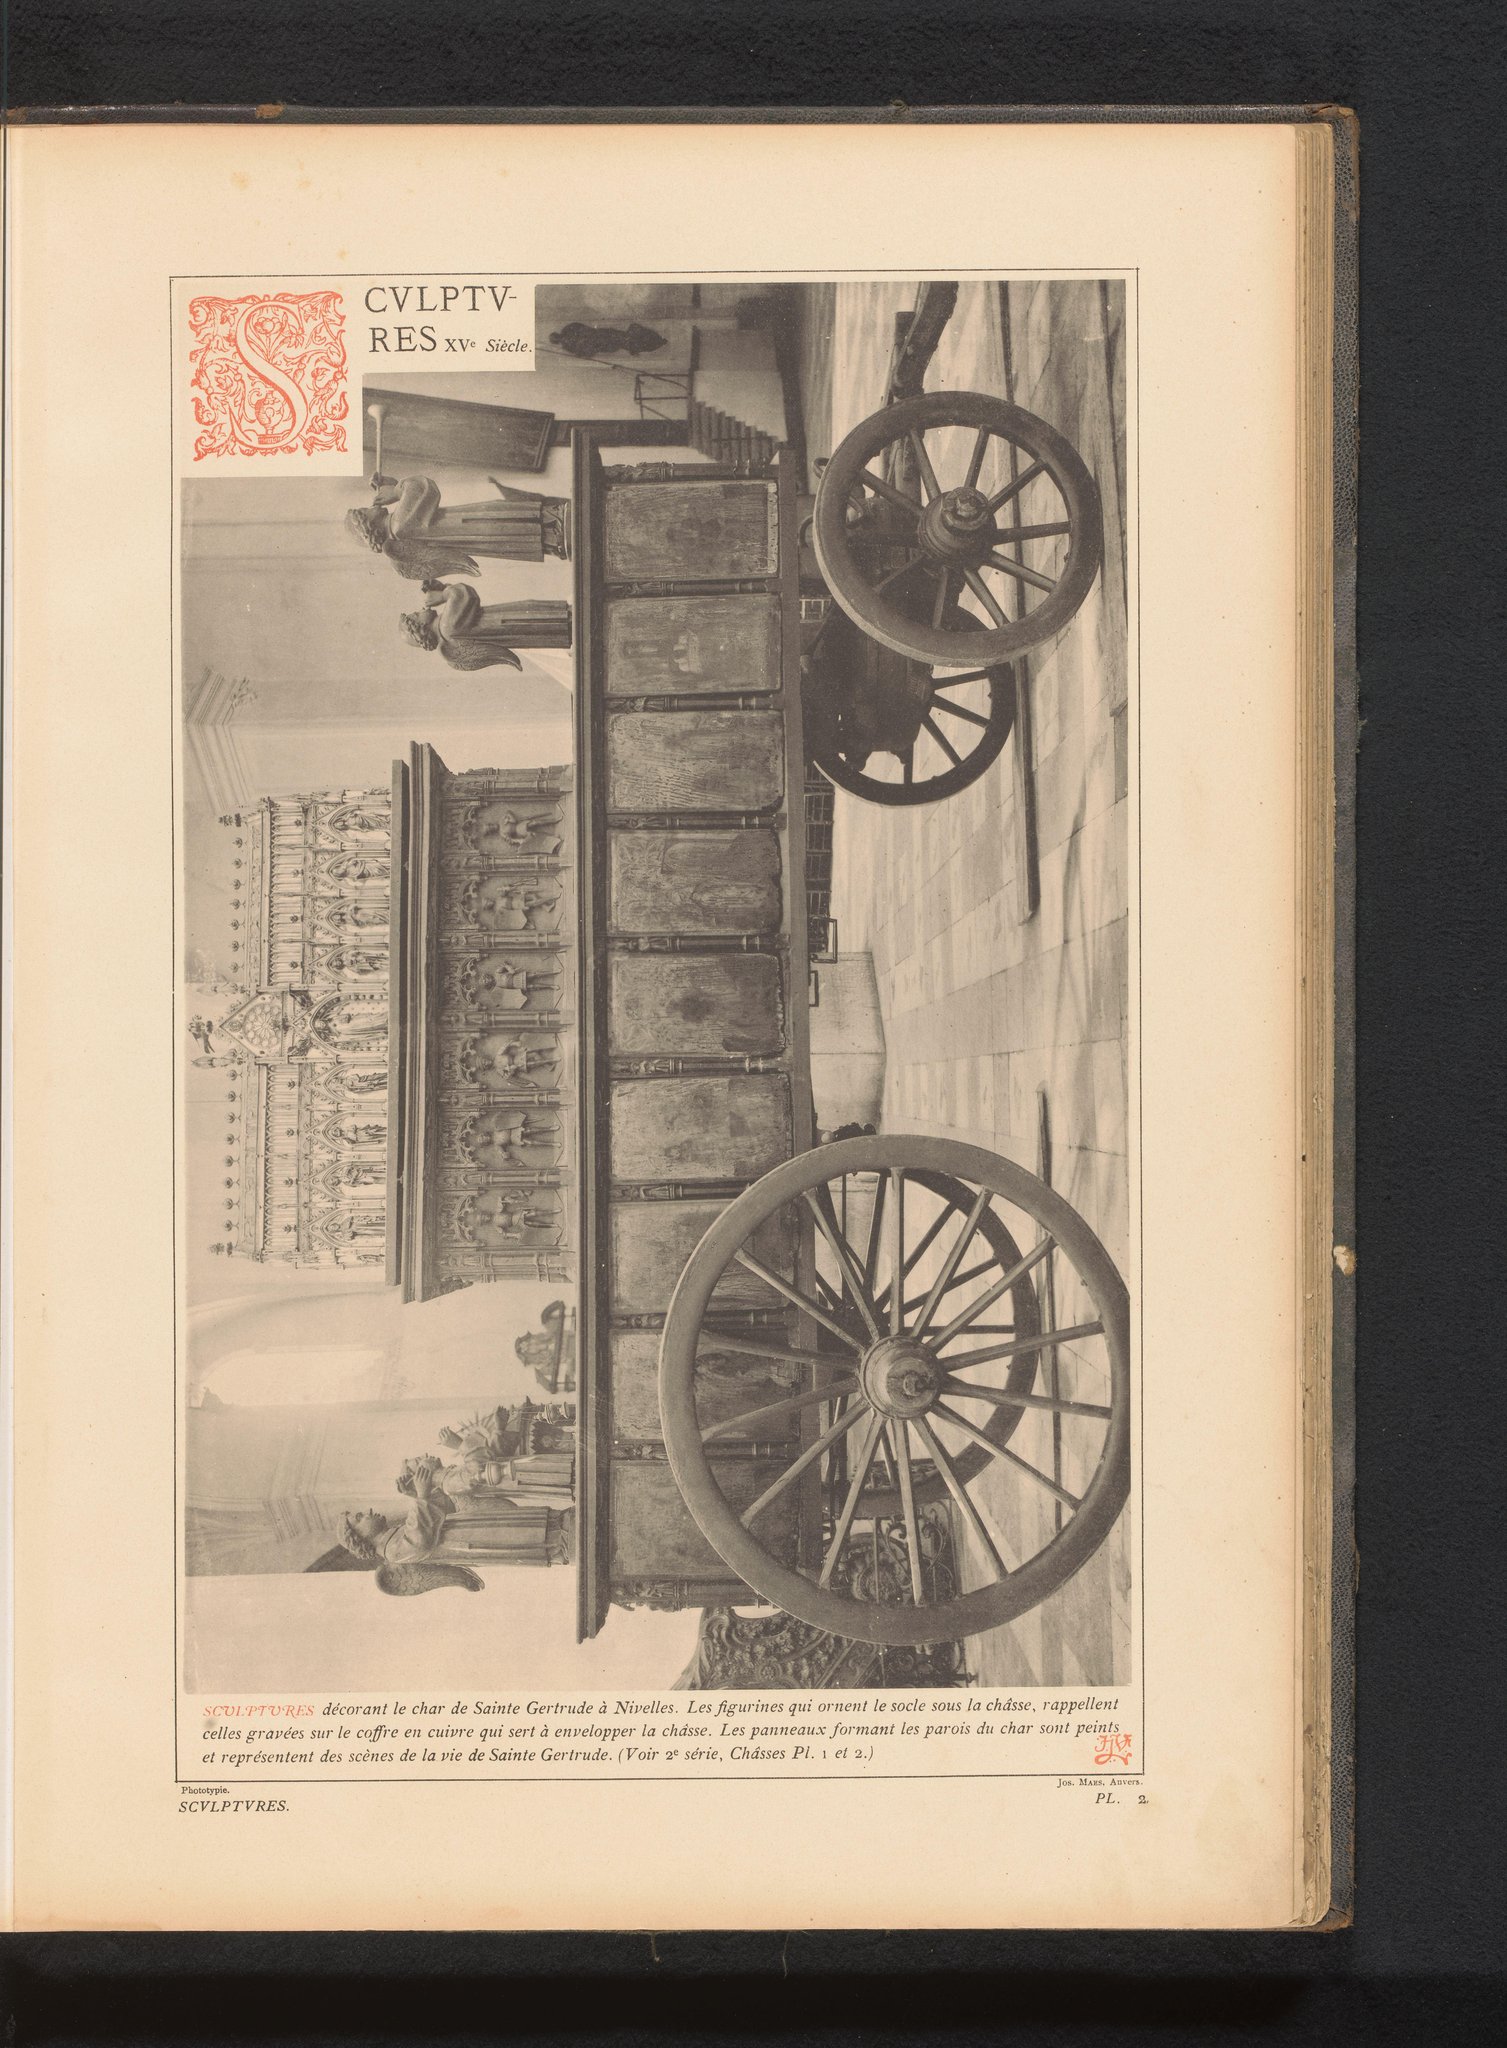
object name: page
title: Sculptures XVe, Siècle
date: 1881-1889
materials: paper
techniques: photograph, photolithography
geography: antwerp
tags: sculpture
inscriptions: monogram: ‘JJvY’, inscription: ‘SCULPTURES. PL. 2.’, inscription: ‘SCULPTURES décorant le (...)’